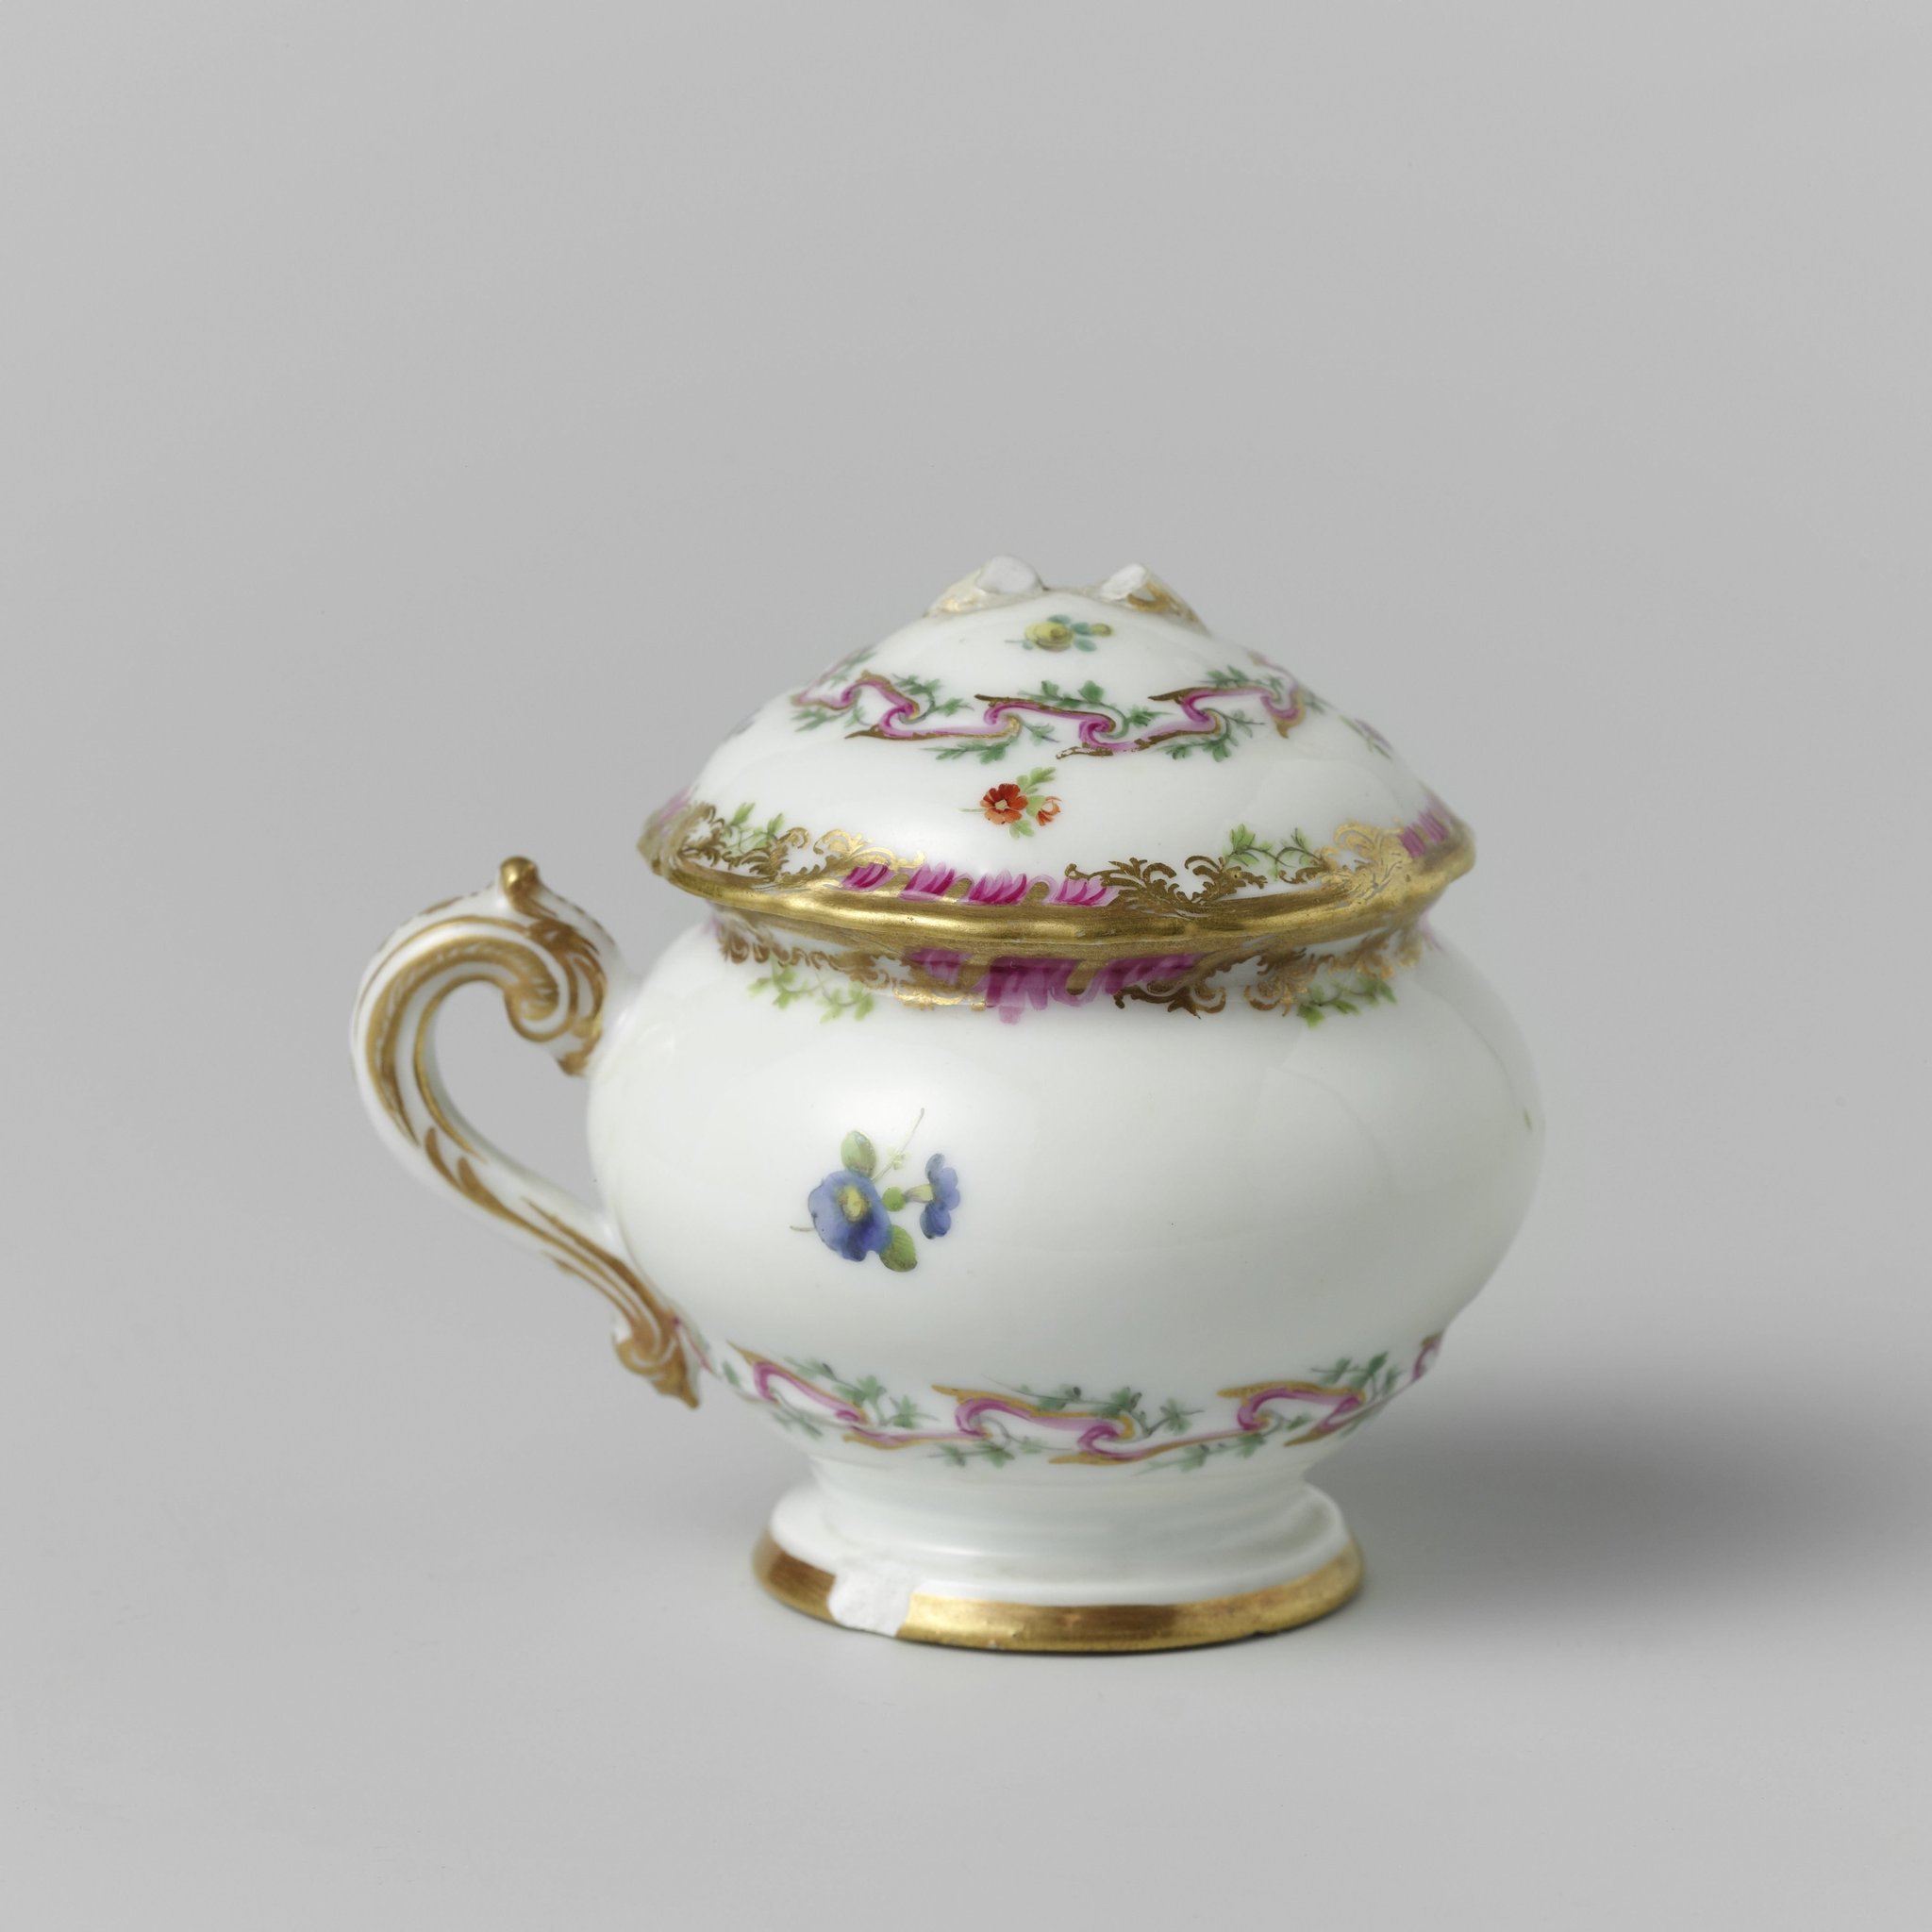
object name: pasteipot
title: Pasteipot, rond, met deksel en oor, behorend bij een servies met geslingerd lintmotief met bladertakken, bloemboeketten en gestrooide bloemtakken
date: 1780-1820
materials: porcelain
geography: loosdrecht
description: Pasteipot, rond, met deksel en oor, behorend bij een servies van porselein met geslingerd motief in paars en goud met groene bladertakken, bloemboeketten en gestrooide bloemtakken. Randen lichtgegolfd met decoratie in goud met paars bladmotief waartussen groen gekruist bladmotief. Gemerkt: M.O.L. en AMSTEL. Serie van elf stuks. Knop van deksel ontbreekt.